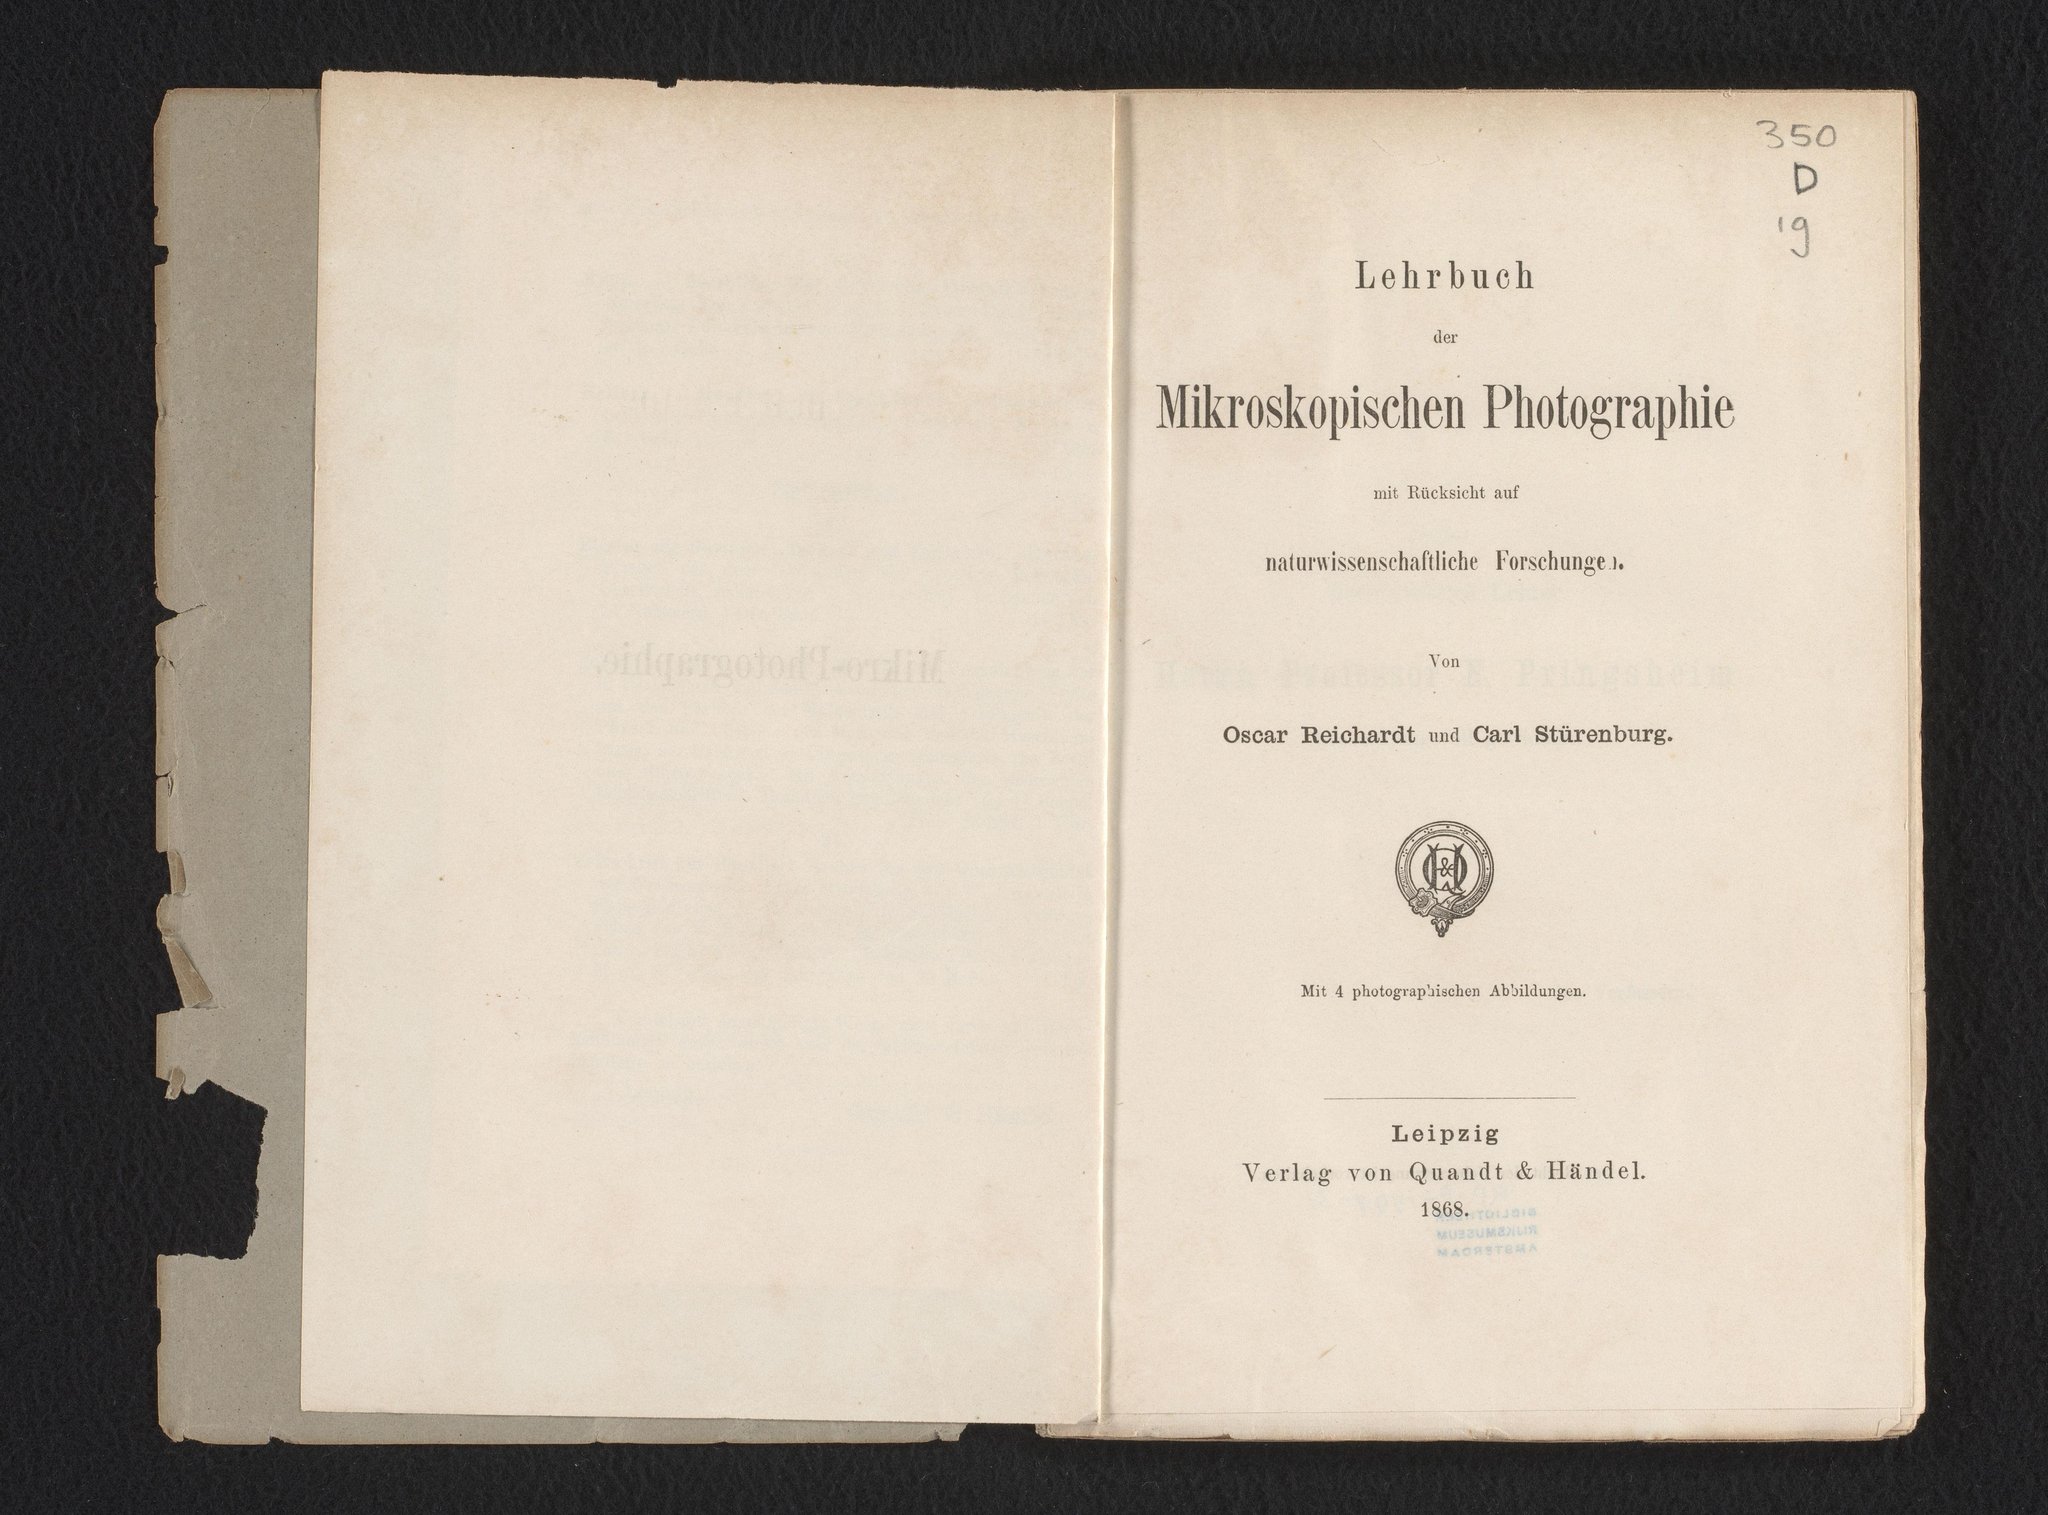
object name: book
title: Lehrbuch der mikroskopischen Photographie mit Rücksicht auf naturwissenschaftliche Forschungen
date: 1868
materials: paper, cardboard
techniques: printing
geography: leipzig